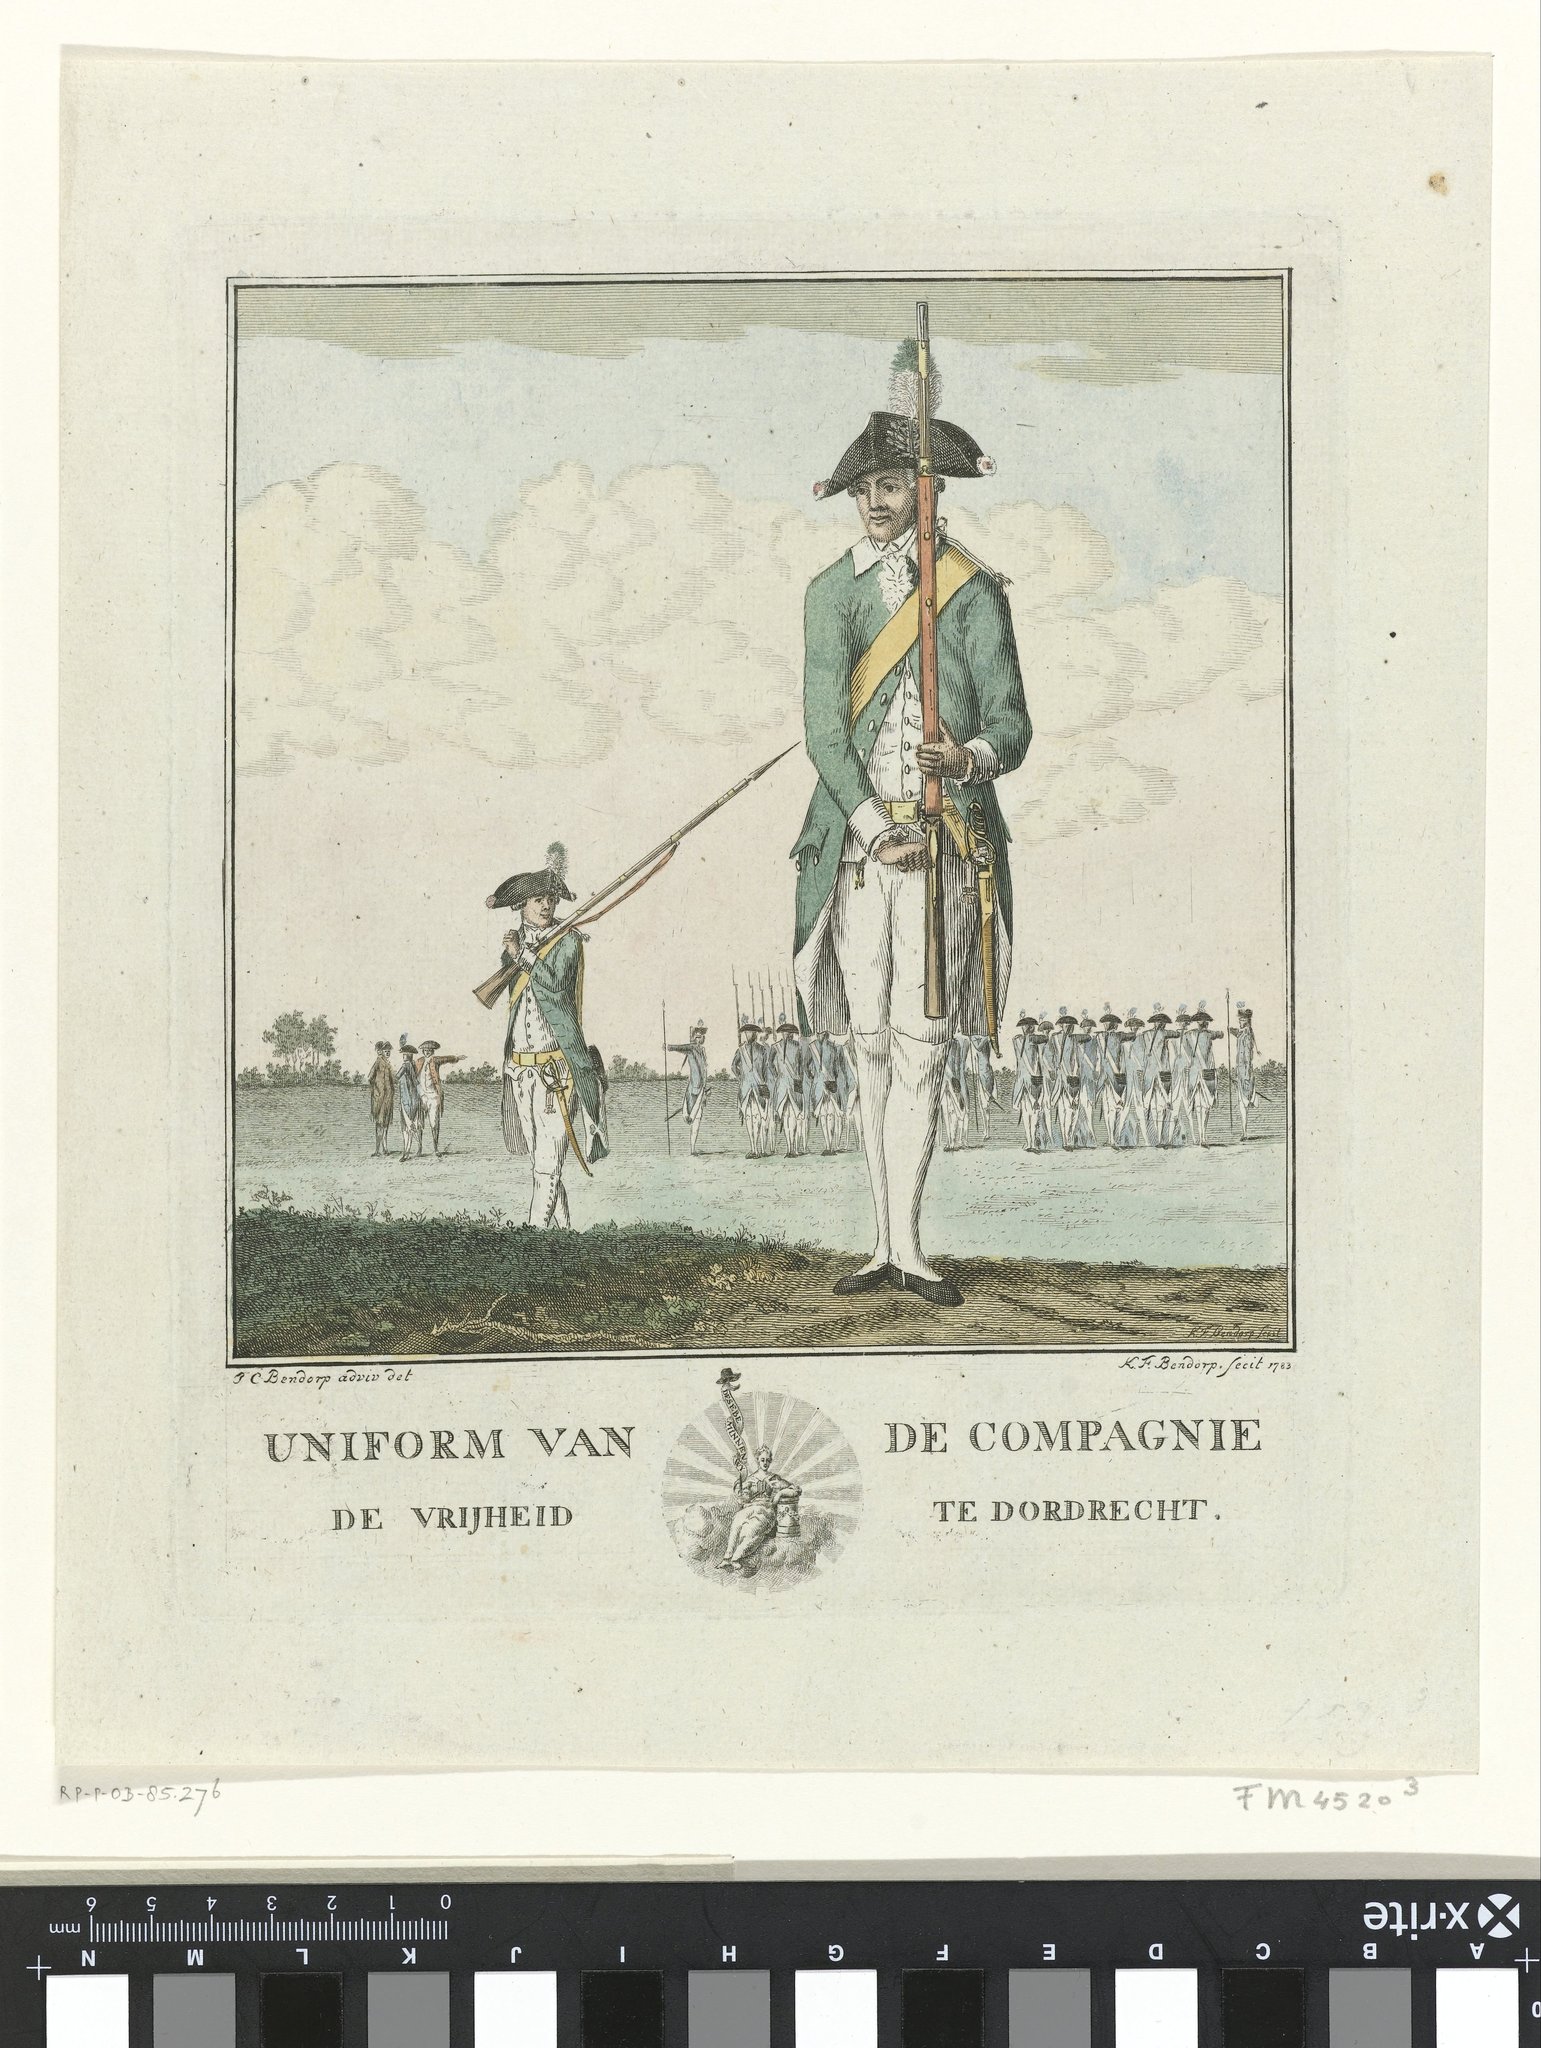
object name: print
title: Uniform van de compagnie De Vrijheid te Dordrecht, 1783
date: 1783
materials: paper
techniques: engraving, etching, hand coloring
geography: northern netherlands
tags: (military) uniforms (+ citizen soldiery, civil guard, citizen militia), drill ~ military training (+ citizen soldiery, civil guard, citizen militia), dordrecht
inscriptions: collector's mark: Lugt 2228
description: Het uniform van het exercitiegenootschap De Vrijheid te Dordrecht, 1783. Op de voorgrond een staande schutter in volle montering, op de achtergrond de exercerende schutterij. In de marge de titel en het wapen van het genootschap.